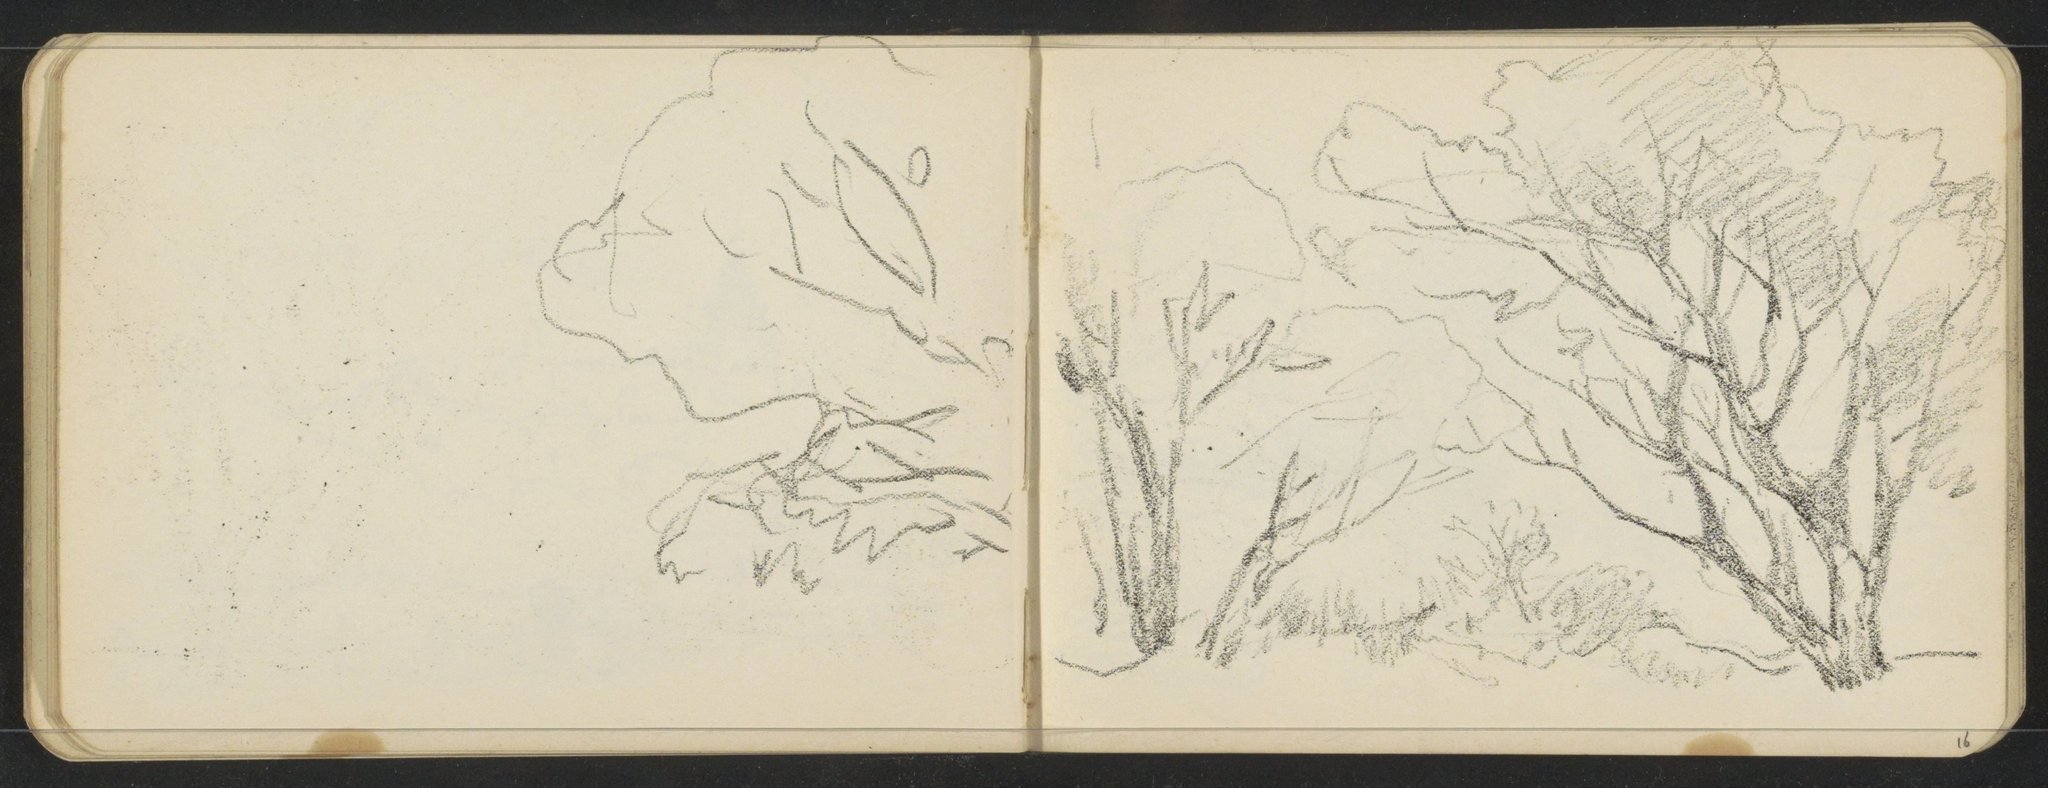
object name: sketchbook leaf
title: Bomen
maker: willem cornelis rip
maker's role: draughtsman, painter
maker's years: 1856-1922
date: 1914-1916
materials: chalk, paper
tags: trees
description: Blad 15 verso en 16 recto uit een schetsboek met 41 bladen.